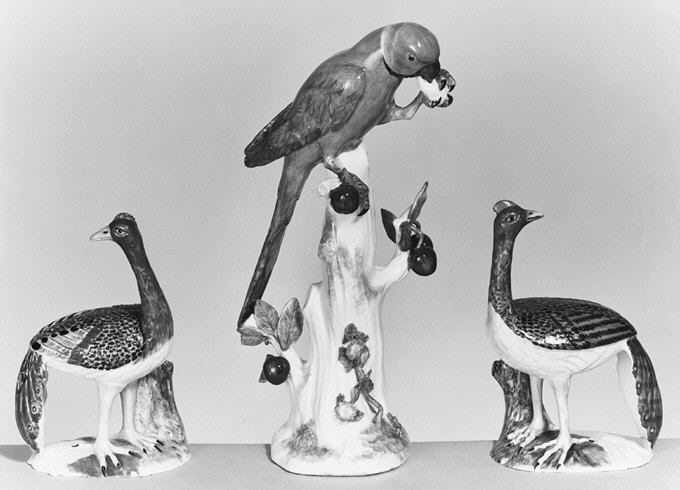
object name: figure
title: Peacock (one of a pair)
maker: meissen manufactory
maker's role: manufactory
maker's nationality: german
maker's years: 1710-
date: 1720-1730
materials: hard paste porcelain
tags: fruit,parrots,peacocks